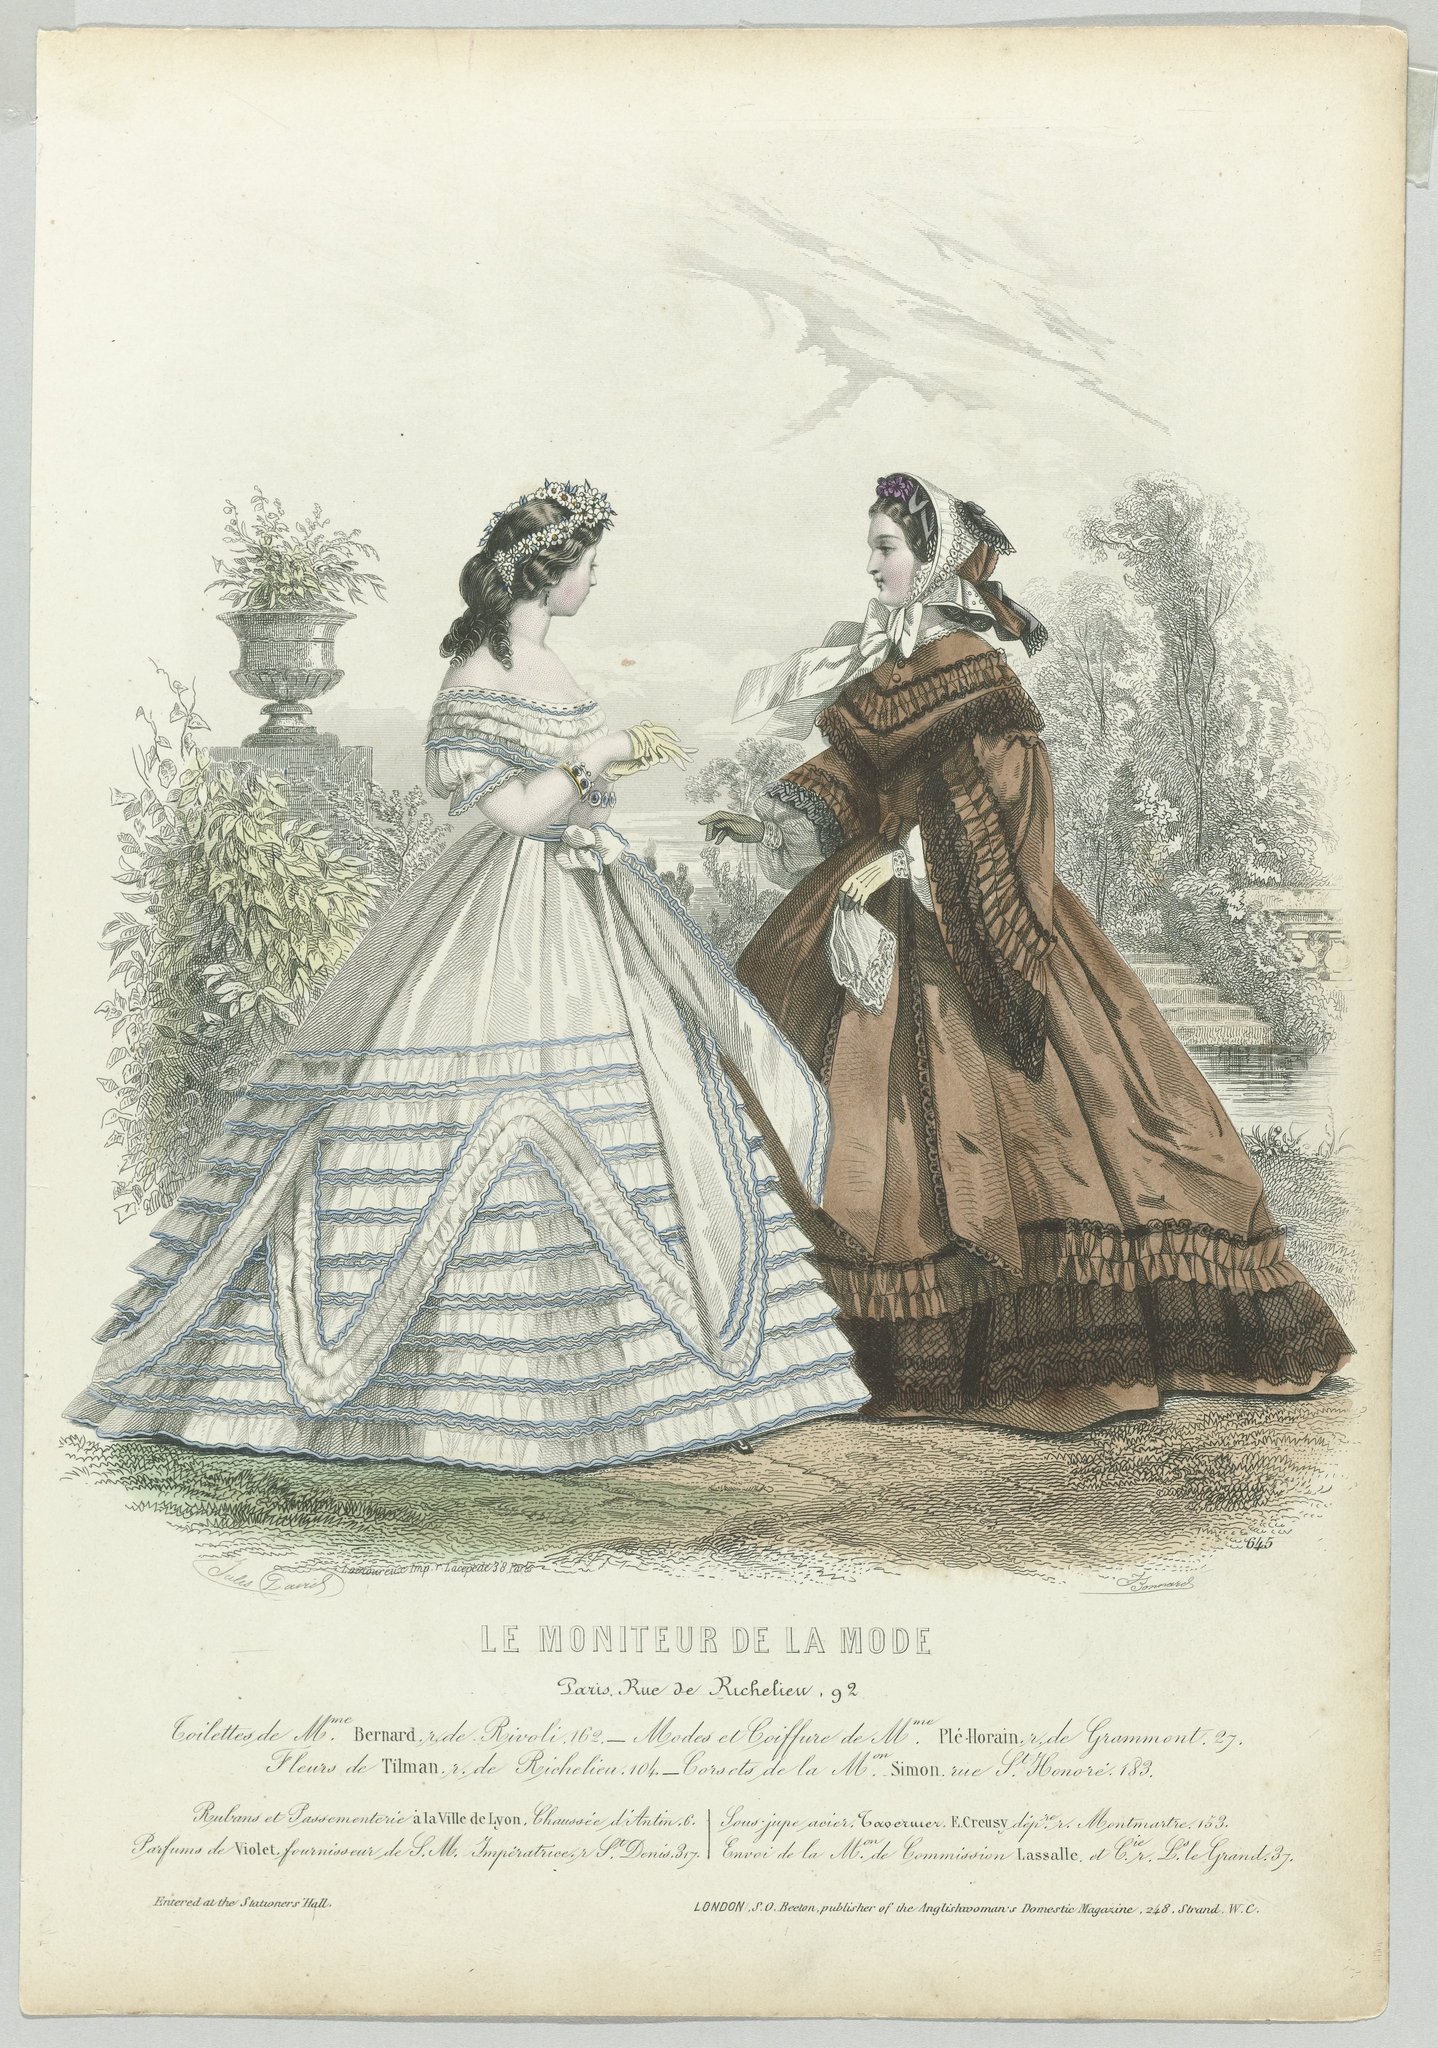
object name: fashion print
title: Le Moniteur de la Mode, 1861, No. 645 : Toilettes de Mme Bernard (...)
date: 1861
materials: paper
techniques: engraving, hand coloring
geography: paris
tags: handkerchief (+ women's clothes), styles of hairdress - aa - ~ women, fashion plates, head-gear: hat (+ women's clothes), gloves, mittens, etc. (+ women's clothes), bracelet, wristlet (+ women's clothes)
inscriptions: caption: ‘Toilettes de M.me Bernard, r. de Rivoli, 162._ Modes et Coiffure de M.me Plé-Horain, r. de Grammont, 27. Fleurs de Tilman, r. de Richelieu. 104_ Corsets de la M.on Simon.rue S.t Honoré, 183. / Rubans et Passementerie à la Ville de Lyon, Chaussée d'Antin, 6. Parfums de Violet, fournisseur de S.M. Impératrice, r. S.t Denis, 317. Sous-jupe acier, Tavernier & Creusy dép.re r. Montmartre, 153. Envoi de la M.on de Commission Lassalle et C.ie r. L.s le Grand, 37.’, address: ‘Paris, Rue de Richelieu, 92. / Entered at the Stationers Hall. S.O. Beeton, publisher of the Anglishwoman's Domestic Magazine, 248, Strand, W.C.’, title: ‘Le Moniteur de la Mode’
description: Twee vrouwen in crinolinejaponnen in een tuin, op de achtergrond een tuinvaas. Volgens het onderschrift: 'toilettes' de Bernard. 'Modes' en 'coiffure' van Plé-Horain. Hieronder enkele regels reclametekst voor verschillende producten. Prent uit het modetijdschrift Le Moniteur de la Mode (1843-1913).